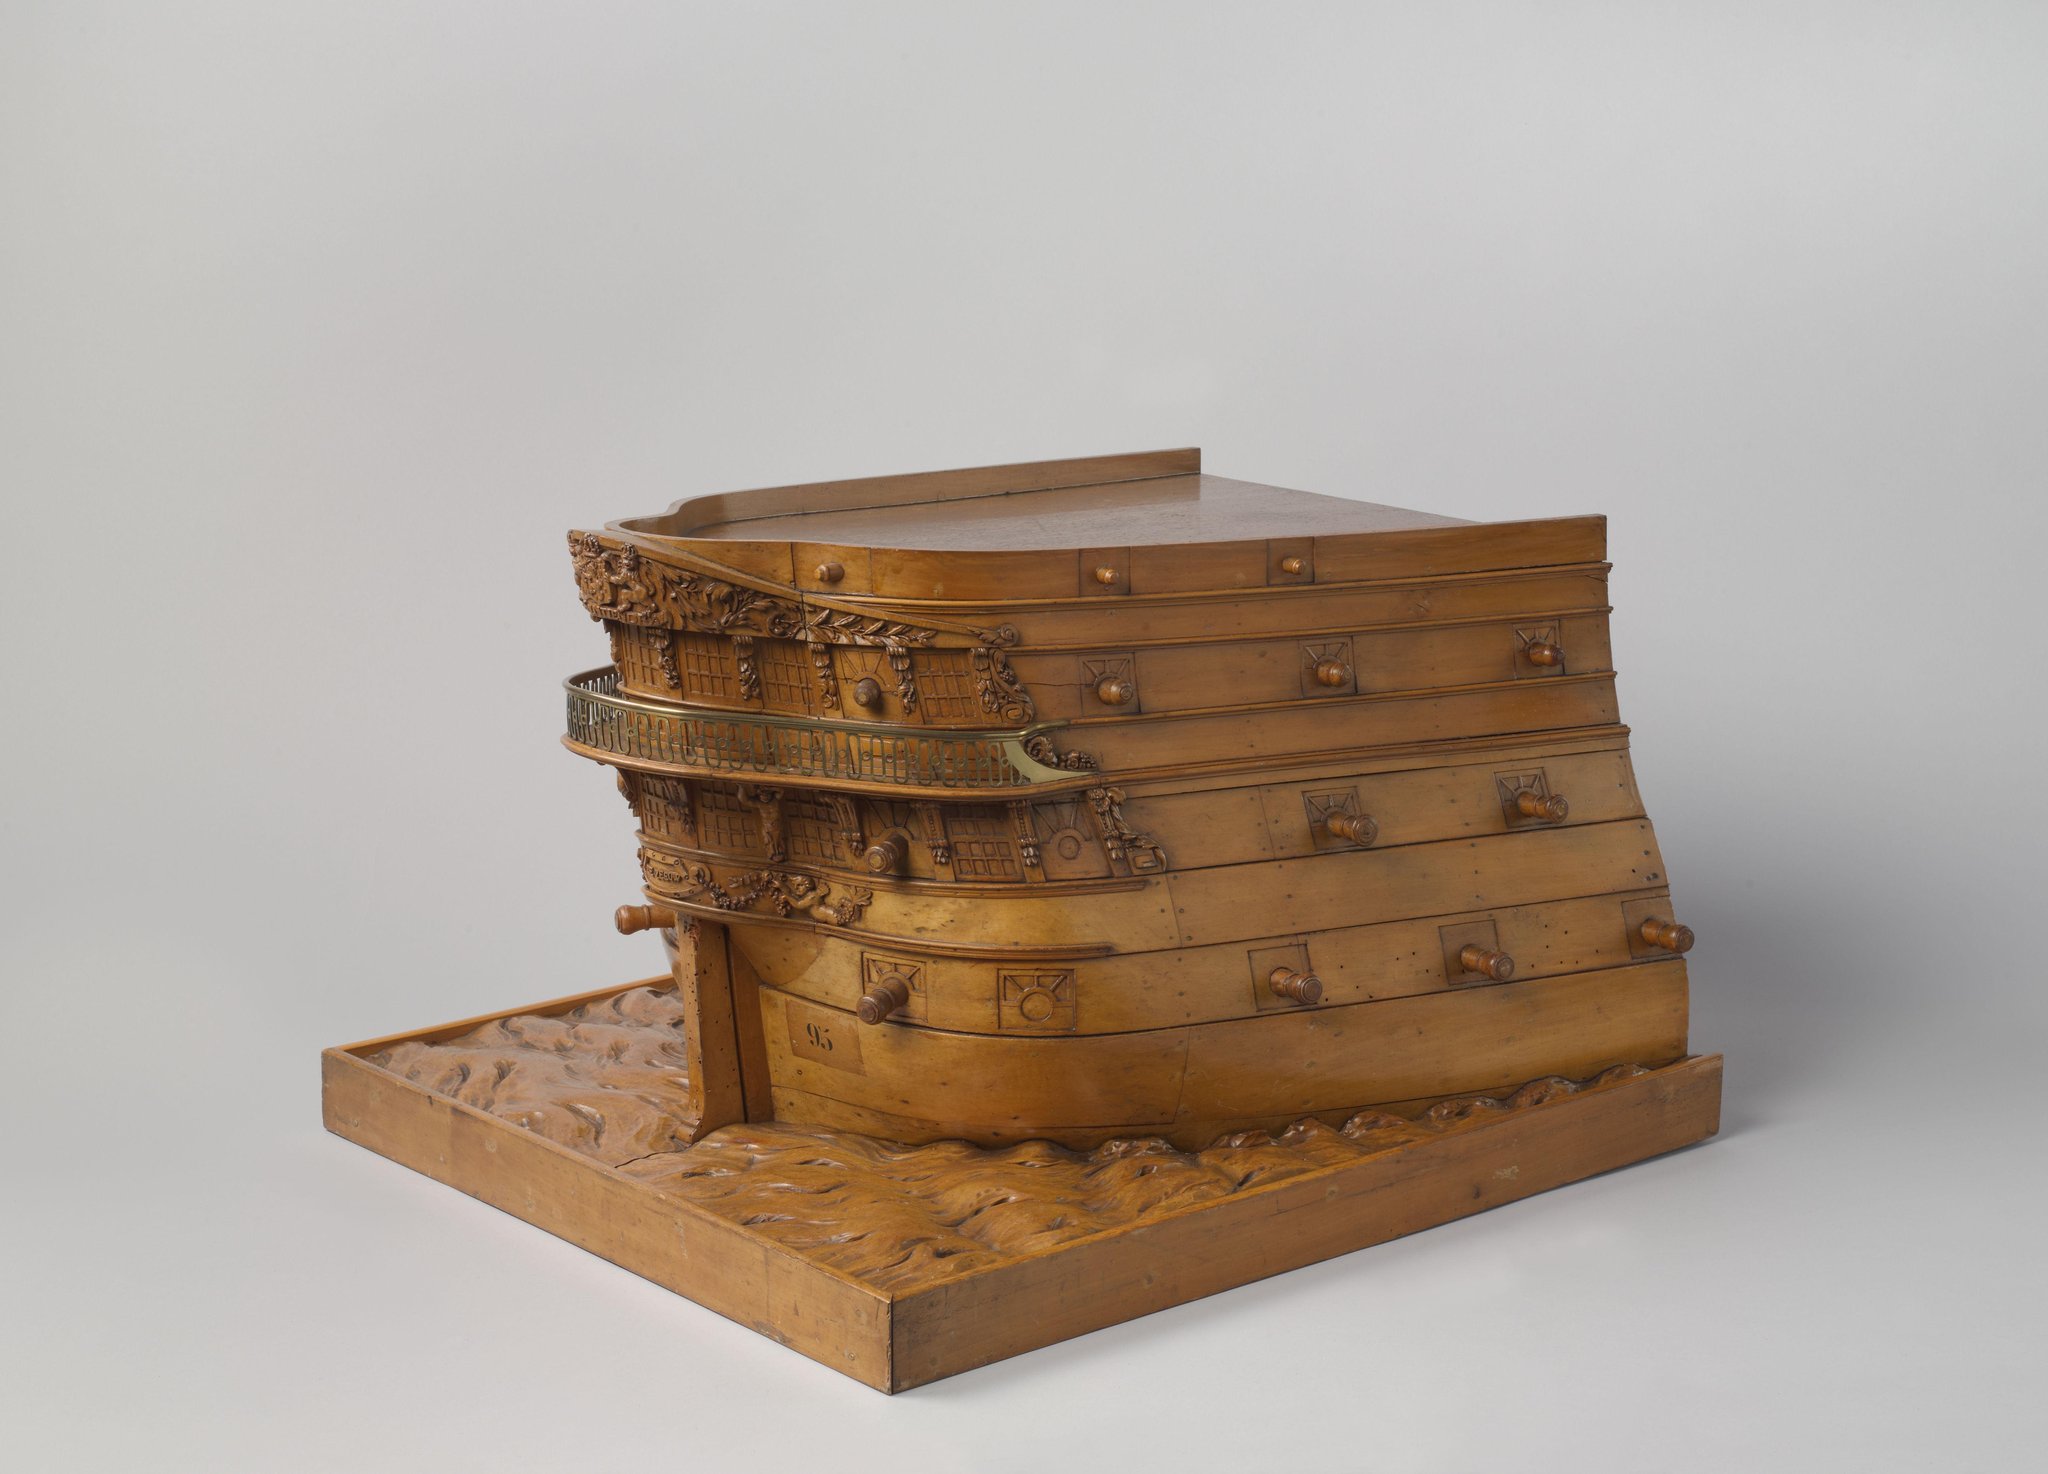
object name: presentation model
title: Model of the Stern of an 84-Gun Ship of the Line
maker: w. janssen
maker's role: model maker, ship modeller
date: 1820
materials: brass, wood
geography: vlissingen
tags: netherlands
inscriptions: inscription, on the deck: ‘Model van het Achter / schip de Zeeuw / in Aanbouw te Vlissingen / ingevolge resolutie van deze / 9. Mei 1820 N1’, inscription, on the taffrail: ‘DE ZEEUW’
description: Waterlijnmodel van de uiterlijke gedaante van een achterschip op een grondplank waarin golven in reliëf zijn gesneden. Rond achterschip met een hek van twee verdiepingen, uitvoerig versierd met trofeeën, mythologische figuren en lofwerk, en met halfronde galerij middenachter. De westergang aan de bovenste verdieping, die om de galerij heenloopt, wordt gesteund door tritons en voluutvormige knieën. Boven het hek het Rijkswapen, onder de galerij het hennegat. Vier dekken worden aangegeven door poorten met vuurmonden. Twee berghouten en twee reehouten.